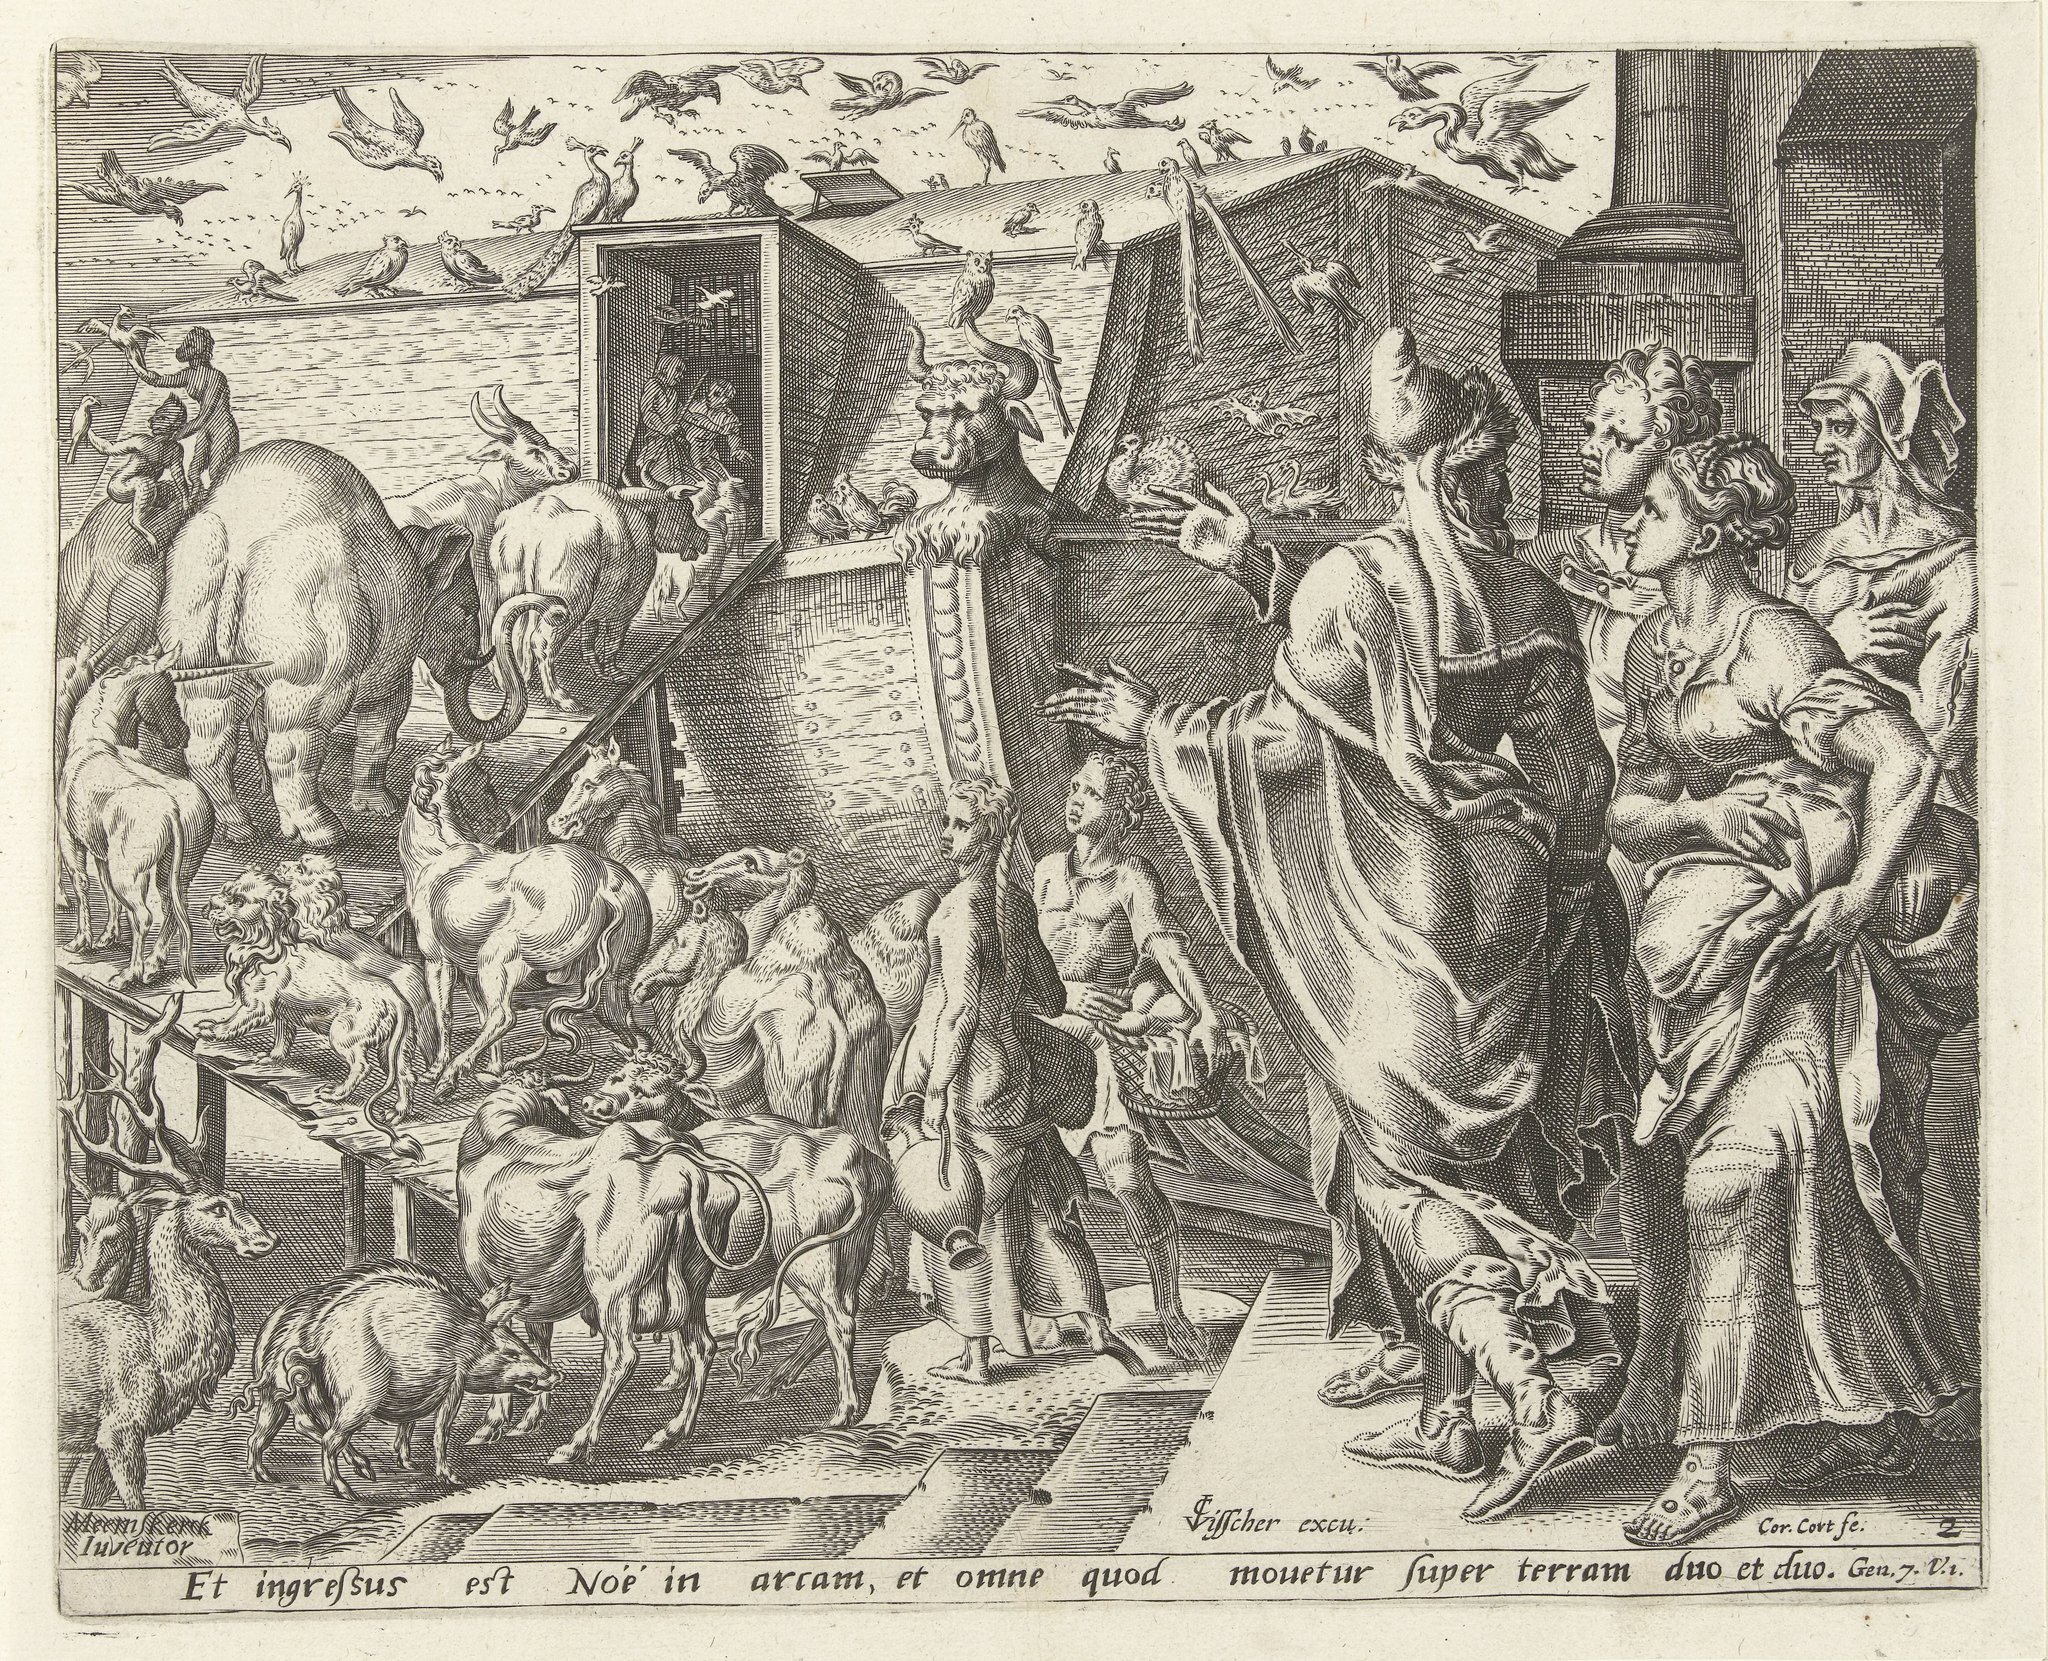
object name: print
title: Noach gaat met zijn familie en de dieren aan boord van de ark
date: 1600-1652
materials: paper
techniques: engraving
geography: amsterdam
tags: the animals enter the ark, noah and his family enter the ark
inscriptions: number: ‘2’, collector's mark: Lugt 2228, address: ‘CIVisscher excu.’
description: Een stoet van dieren trekt de ark binnen, van elk soort een paar. Boven de ark een zwerm vogels. Rechtsvoor Noach en zijn familie.